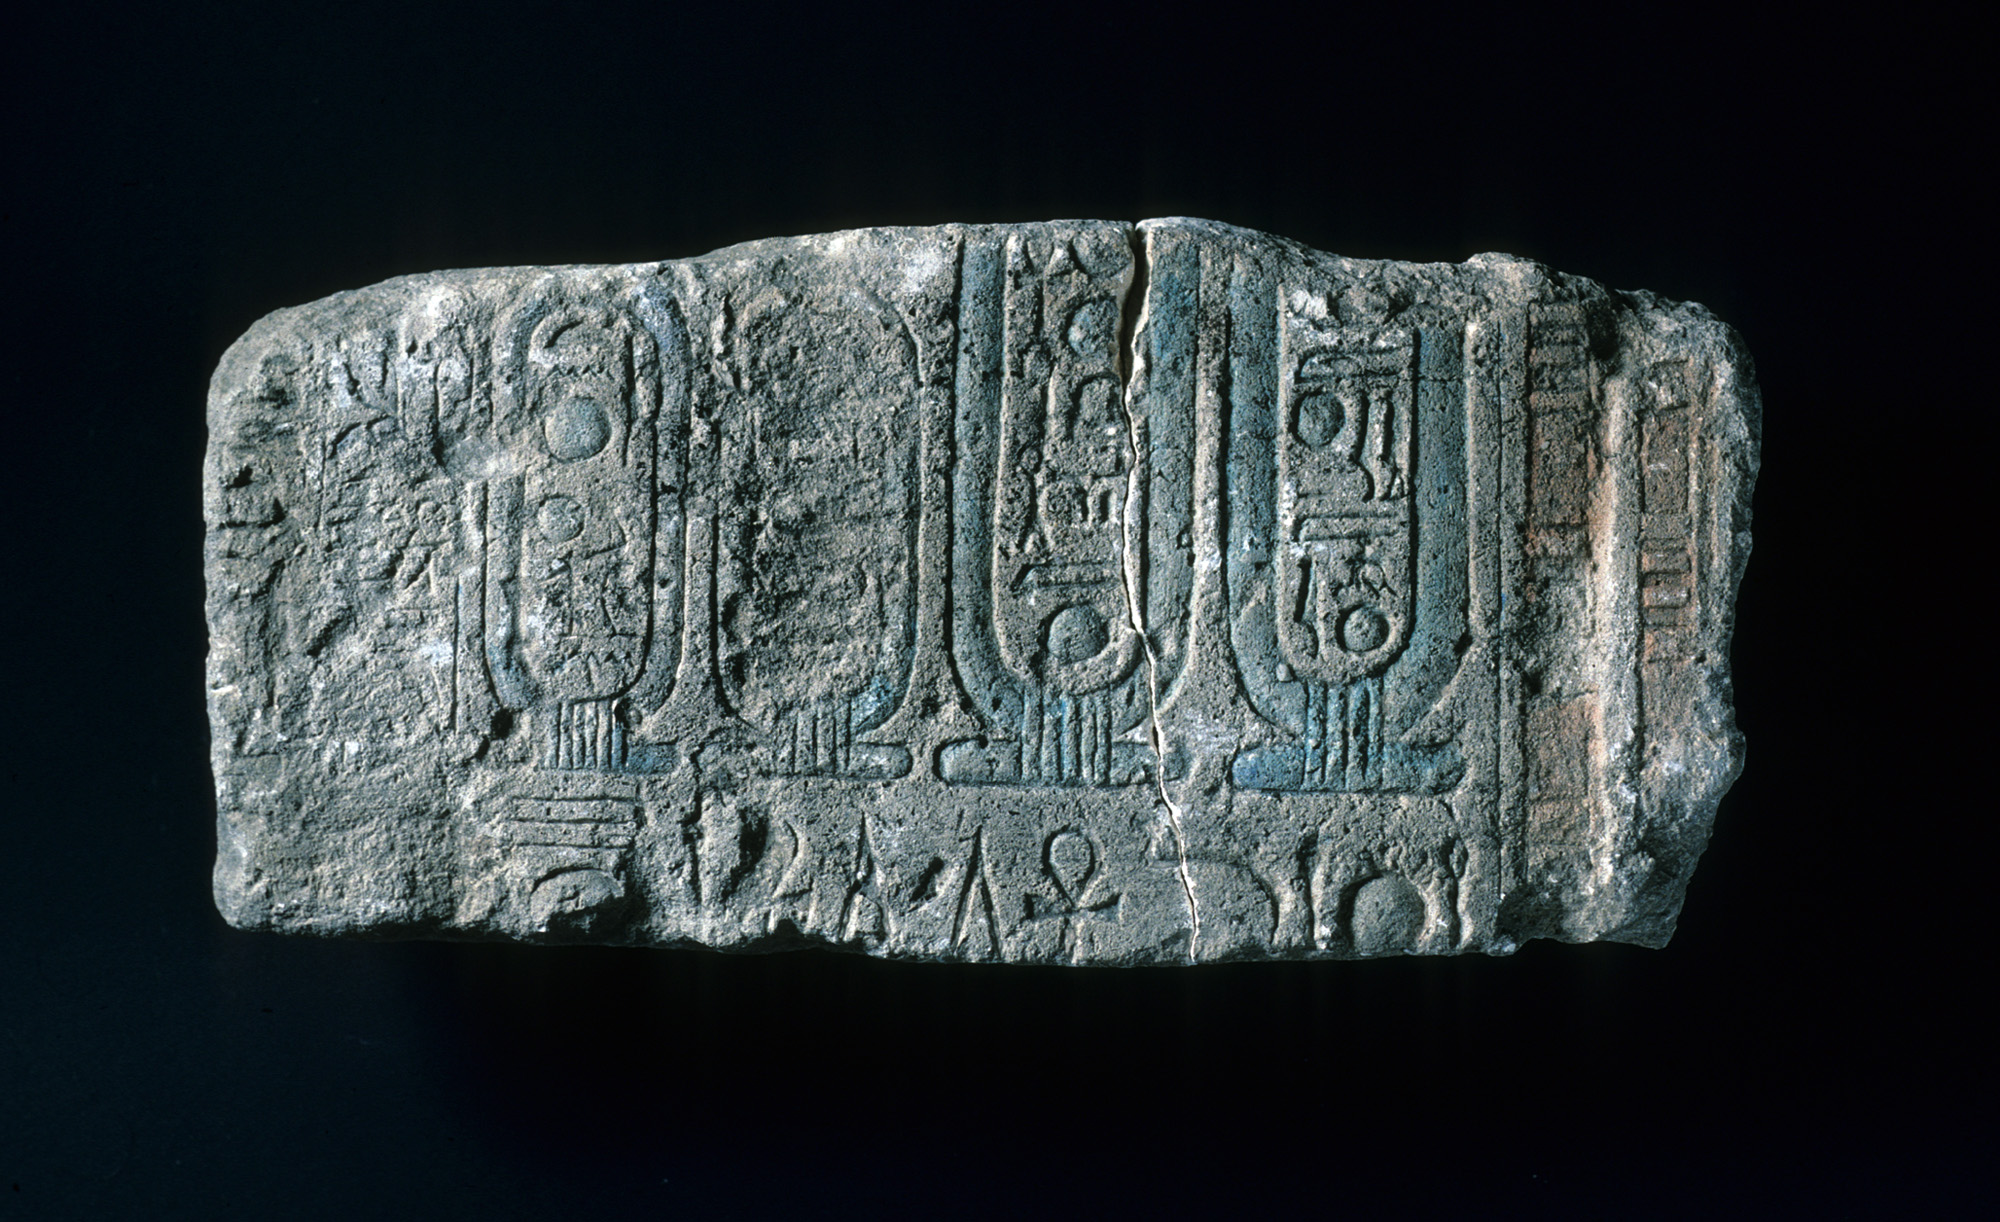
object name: talatat, cartouch, akhenaten, aten, kiya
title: Relief with cartouches of Akhenaten, the Aten and Kiya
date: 1353-1336 BCE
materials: limestone, paint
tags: cartouches